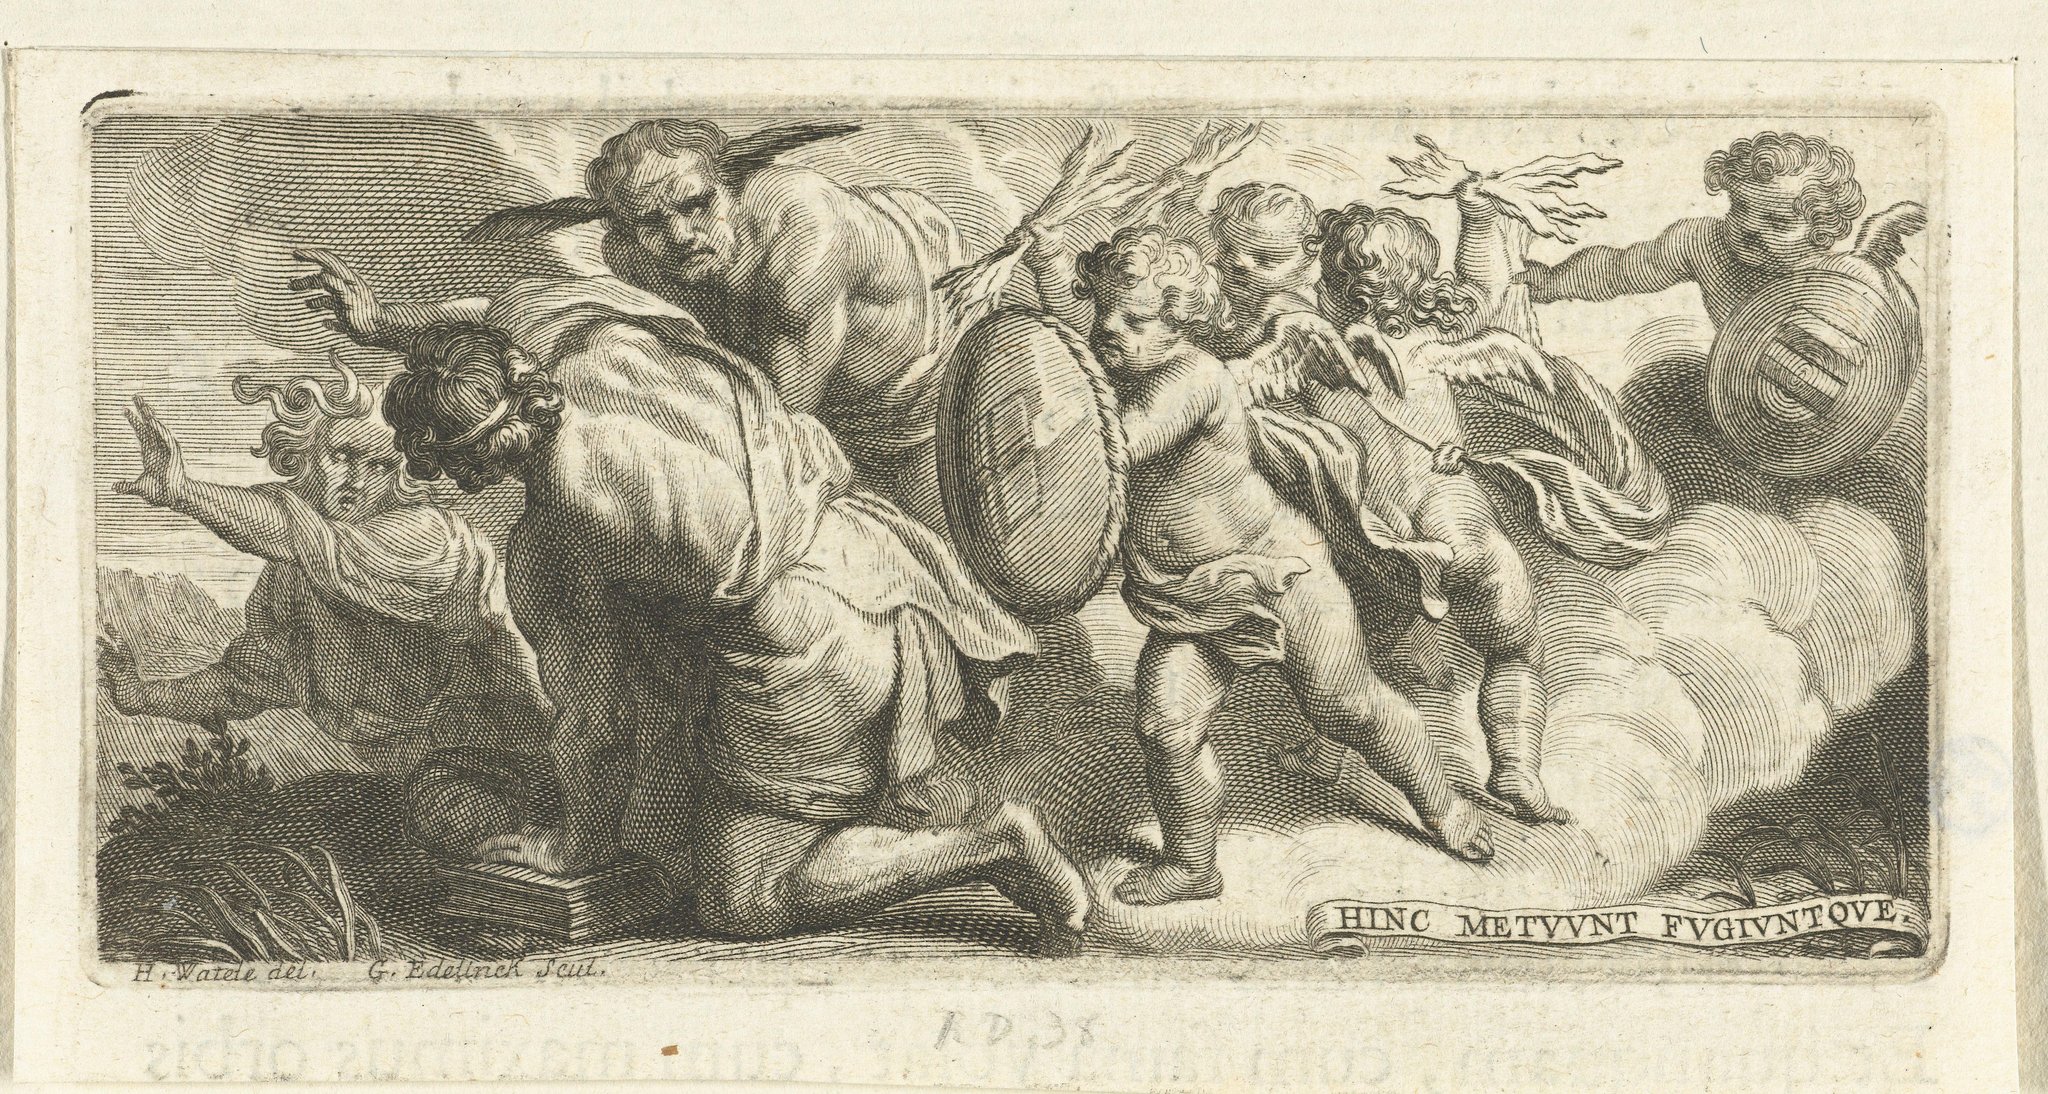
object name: print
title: Cherubijnen bestrijden Onwetendheid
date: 1666-1707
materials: paper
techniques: engraving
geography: paris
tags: ignorance; 'ignoranza', 'ignoranza di tutte le cose', 'ignoranza in un ricco senza lettere' (ripa)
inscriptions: collector's mark: Lugt 2228, collector's mark: Lugt 1337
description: Vier cherubijnen gewapend met bliksemschichten en schilden, verdrijven Onwetendheid in de vorm van drie personen. Op een banderol een Latijnse tekst. De achterkant van de prent is bedrukt met tekst in Latijn.